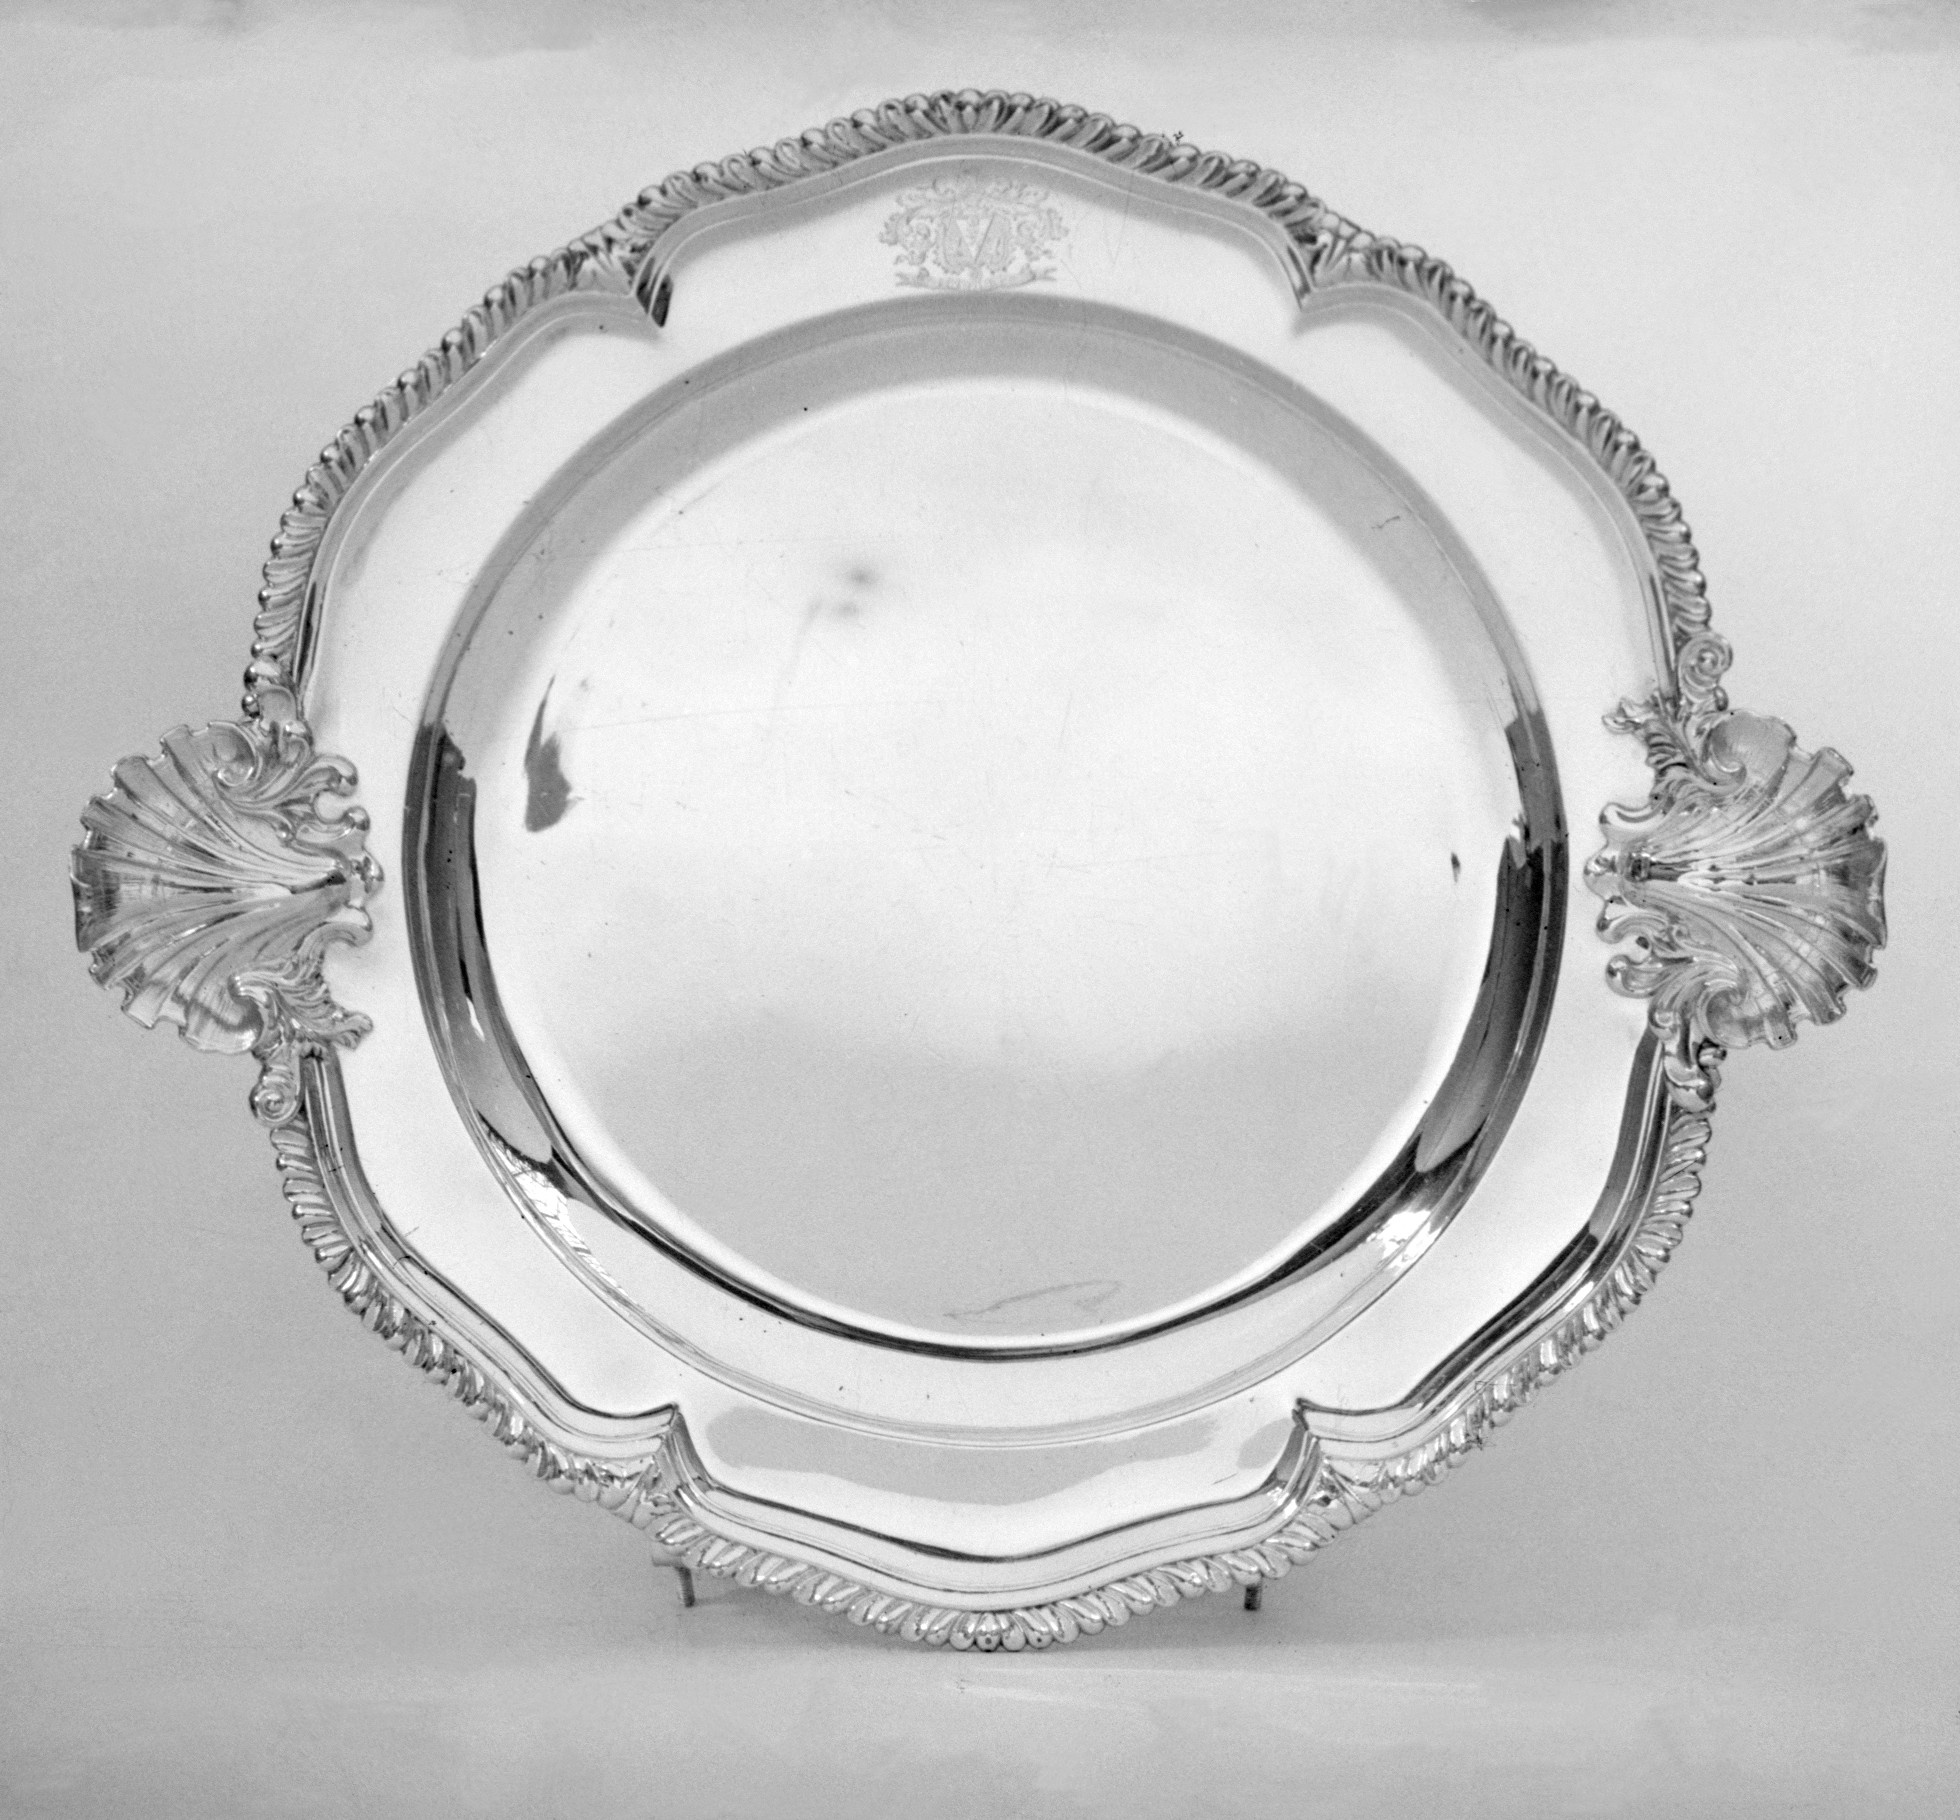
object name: dish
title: Dish (one of a graduated set of seven)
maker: paul de lamerie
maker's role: maker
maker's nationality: british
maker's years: 1688-1751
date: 1741-1742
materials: silver